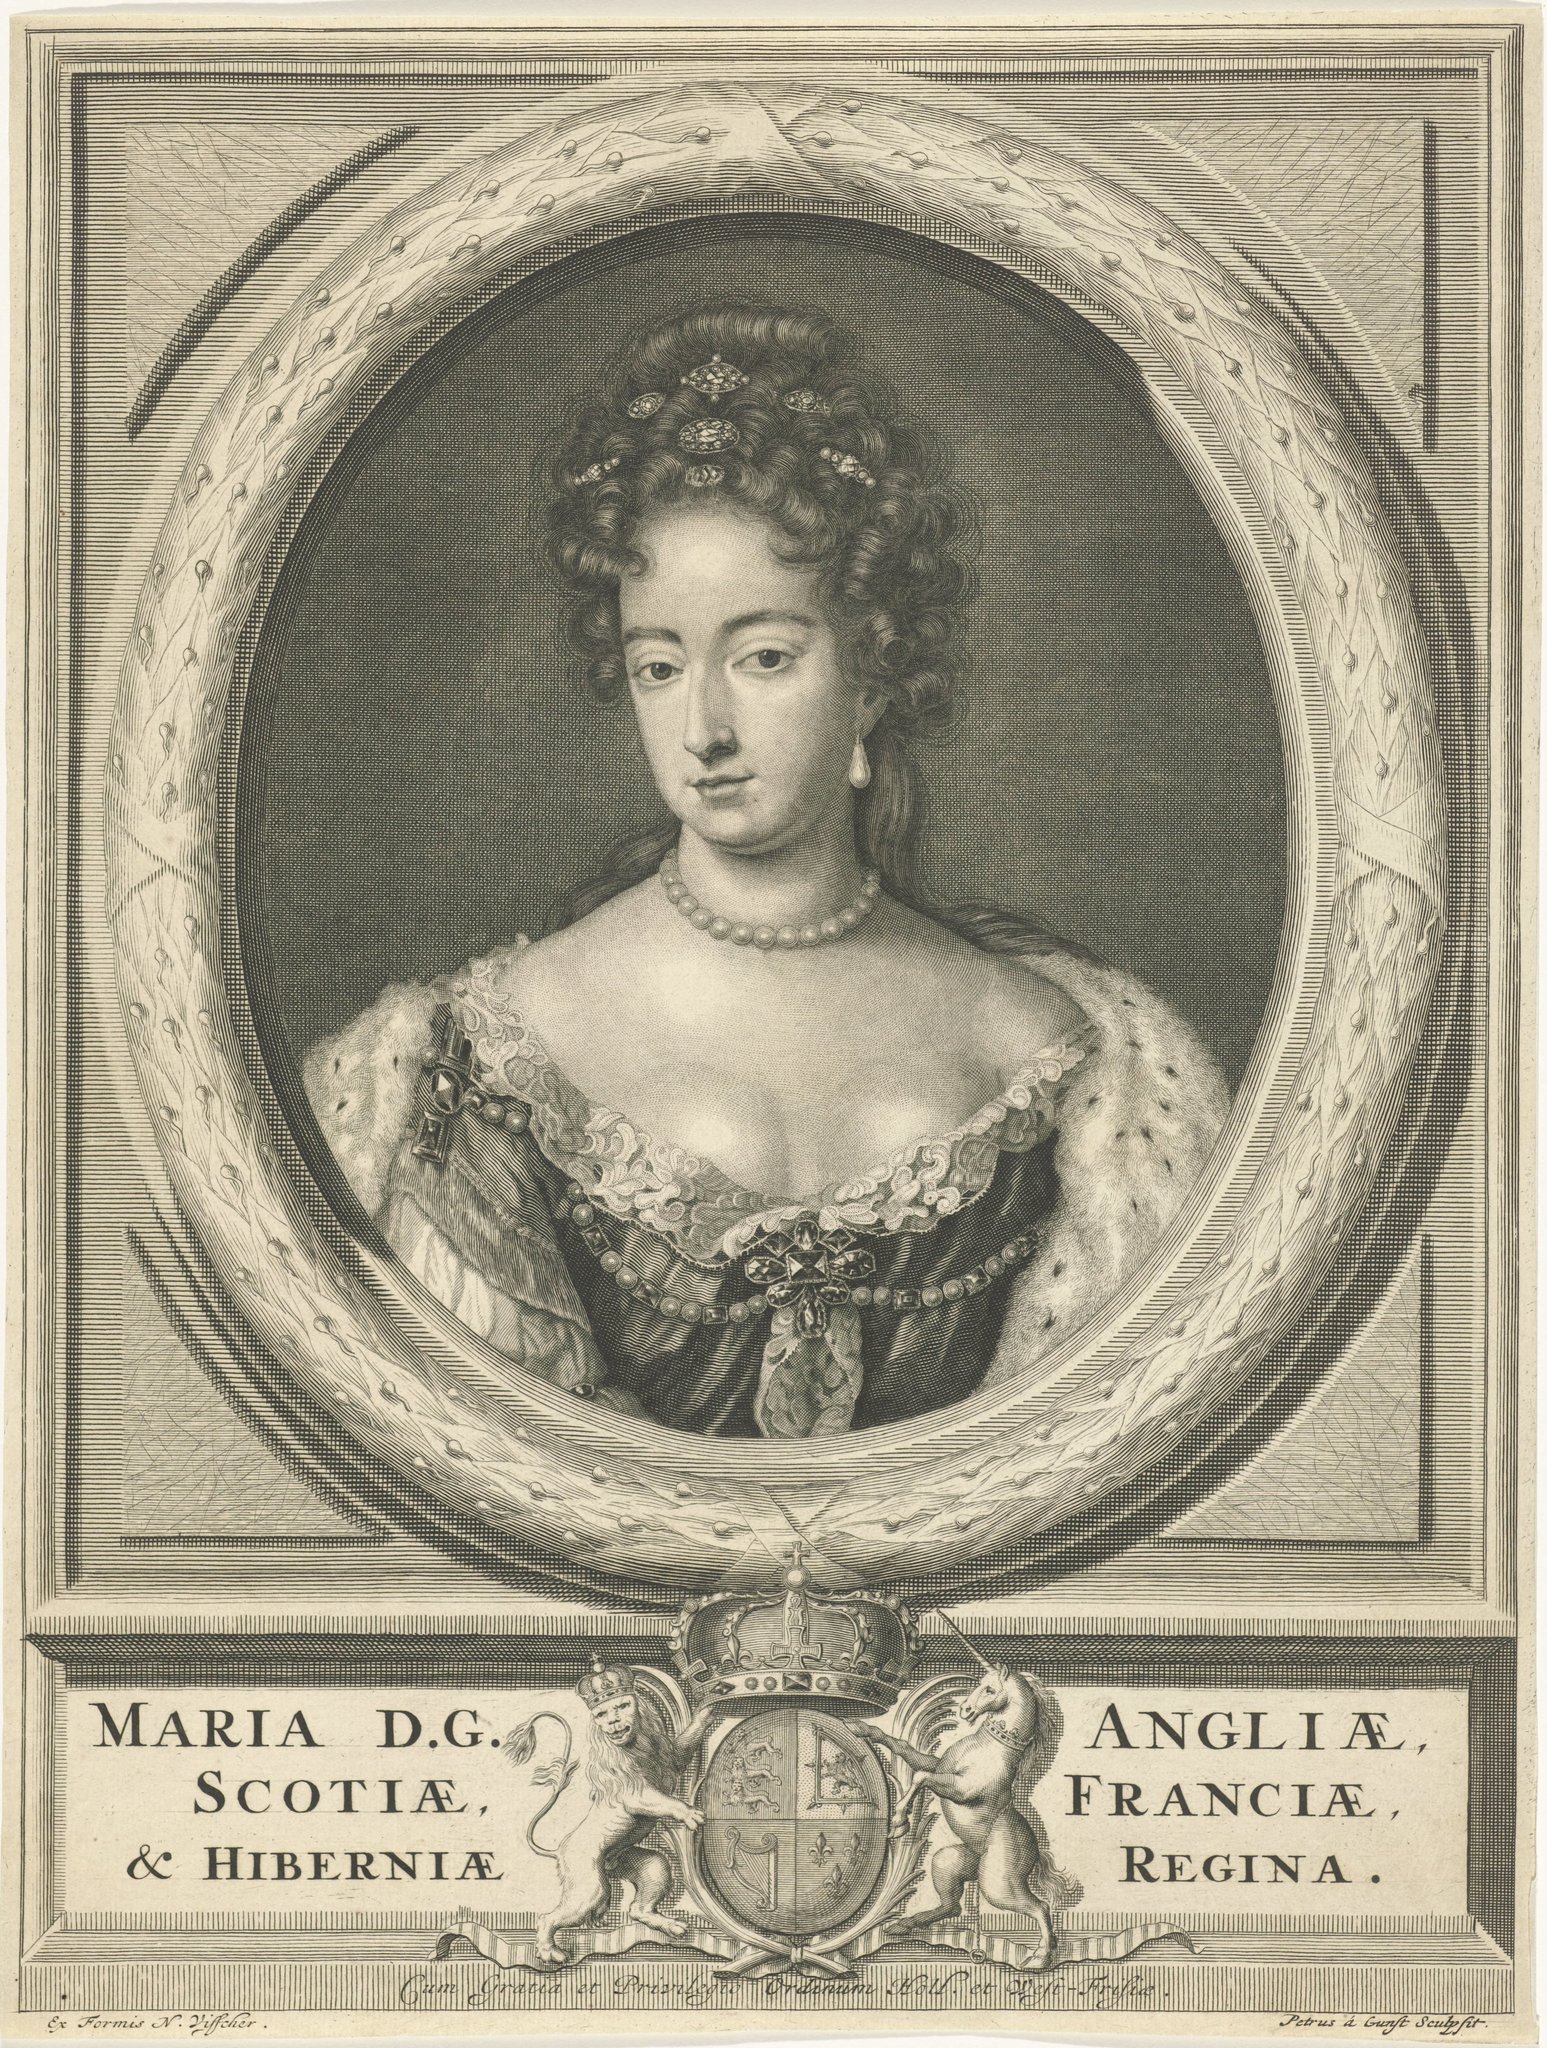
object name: print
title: Portret van koningin Maria II Stuart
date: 1688-1709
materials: paper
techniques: engraving, etching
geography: amsterdam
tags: london, maria ii stuart (koningin van engeland, schotland en ierland)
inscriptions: collector's mark: Lugt 240, collector's mark: Lugt 2228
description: Maria II Stuart, koningin van Engeland en Schotland. Onder de prent haar wapenschild.